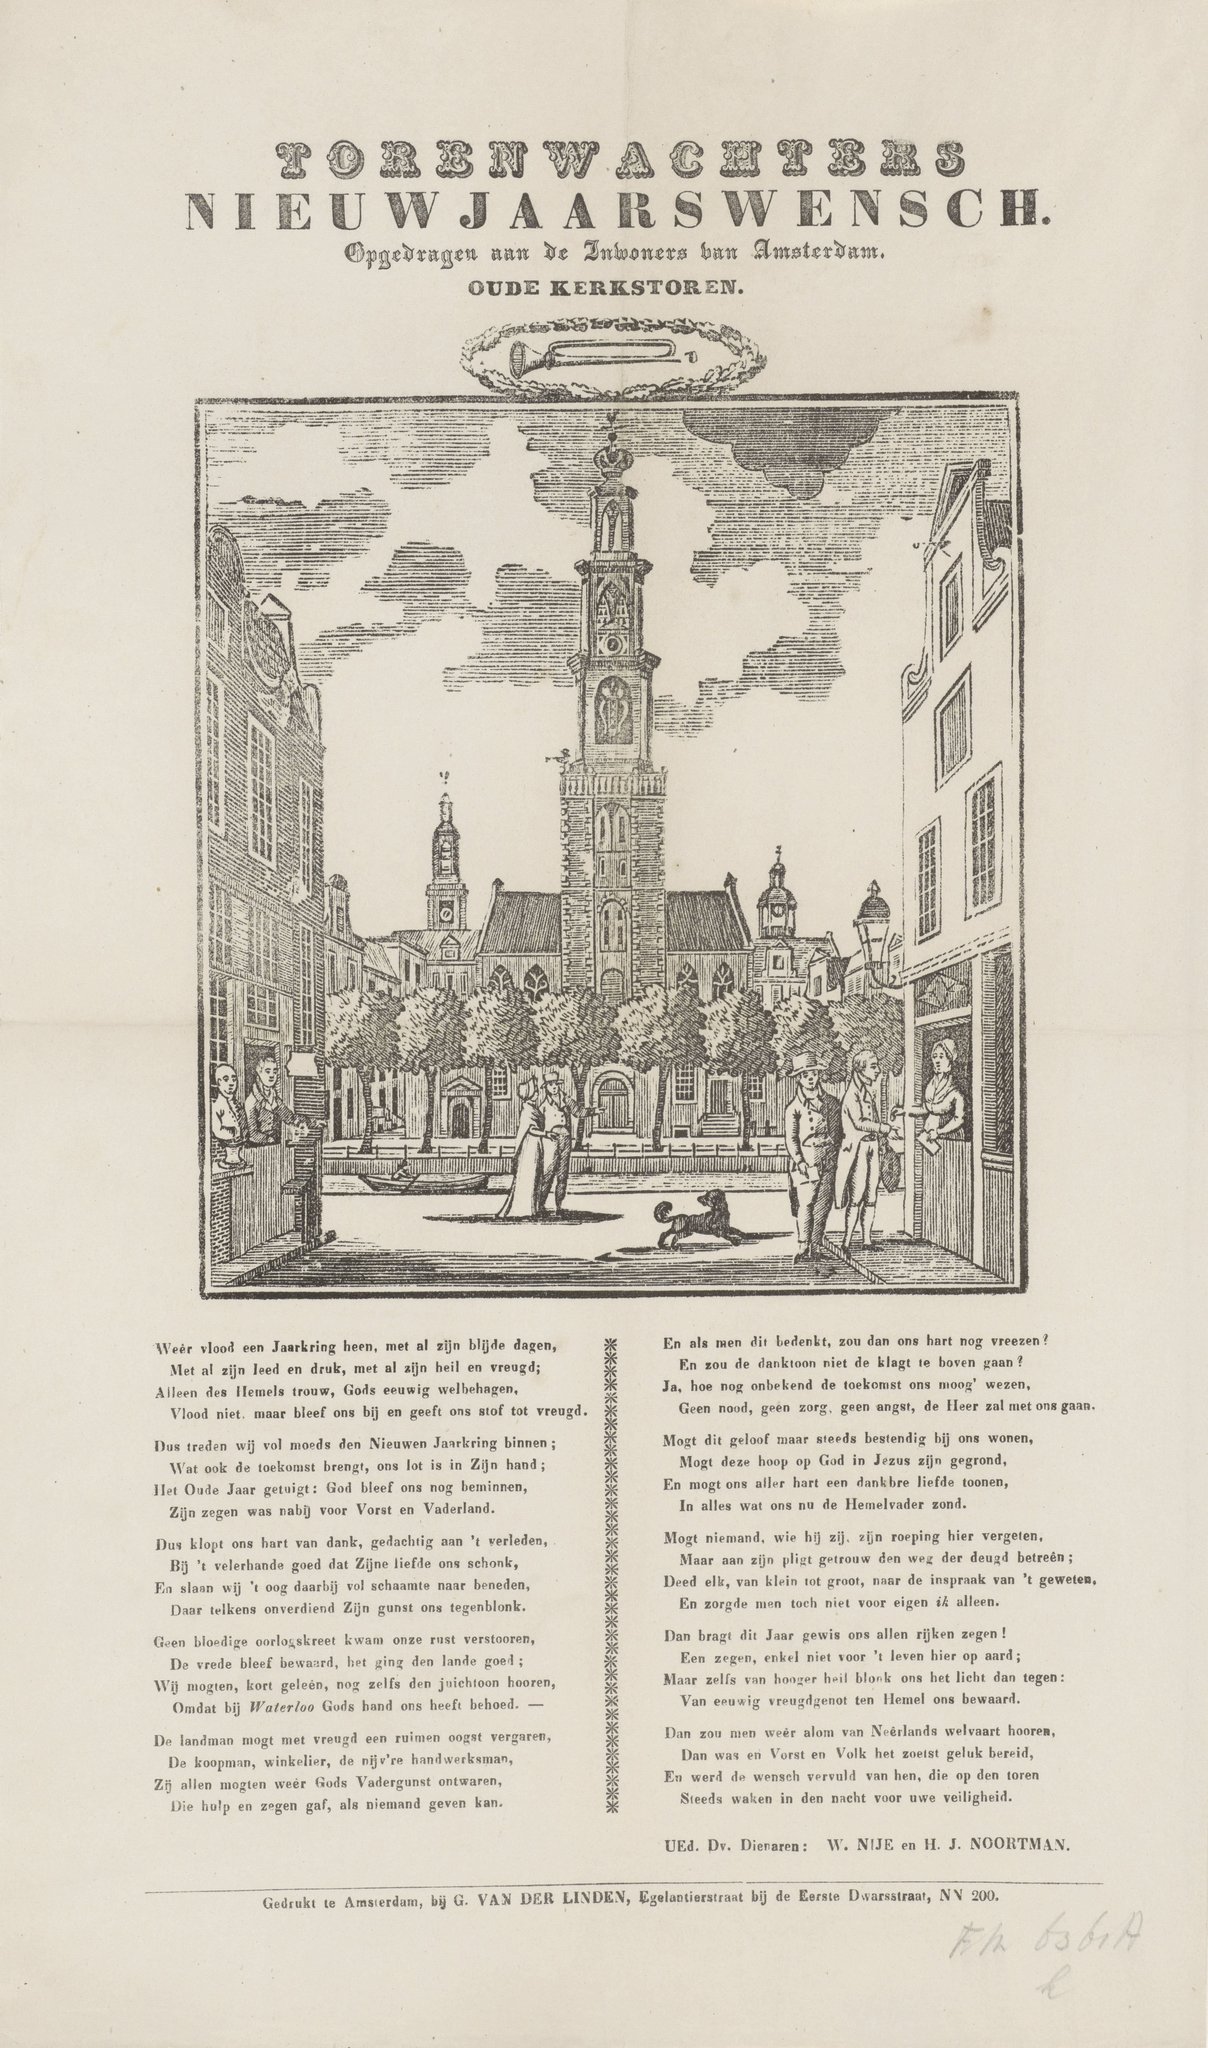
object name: new year card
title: Torenwachters Nieuwjaarswensch (...) Oude Kerkstoren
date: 1840-1870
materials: paper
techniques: letterpress printing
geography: amsterdam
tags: tower sentry, street, amsterdam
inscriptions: collector's mark: Lugt 2228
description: Nieuwjaarswens van de torenwachters van de Amsterdamse Oude Kerk, ca. 1840-1870. Gezicht op de Westerkerk te Amsterdam, twee mannen halen aan de huizen geld op. Onderaan een gedicht in twee kolommen. Van de torenwachters: W. Nije en H.J. Noortman.